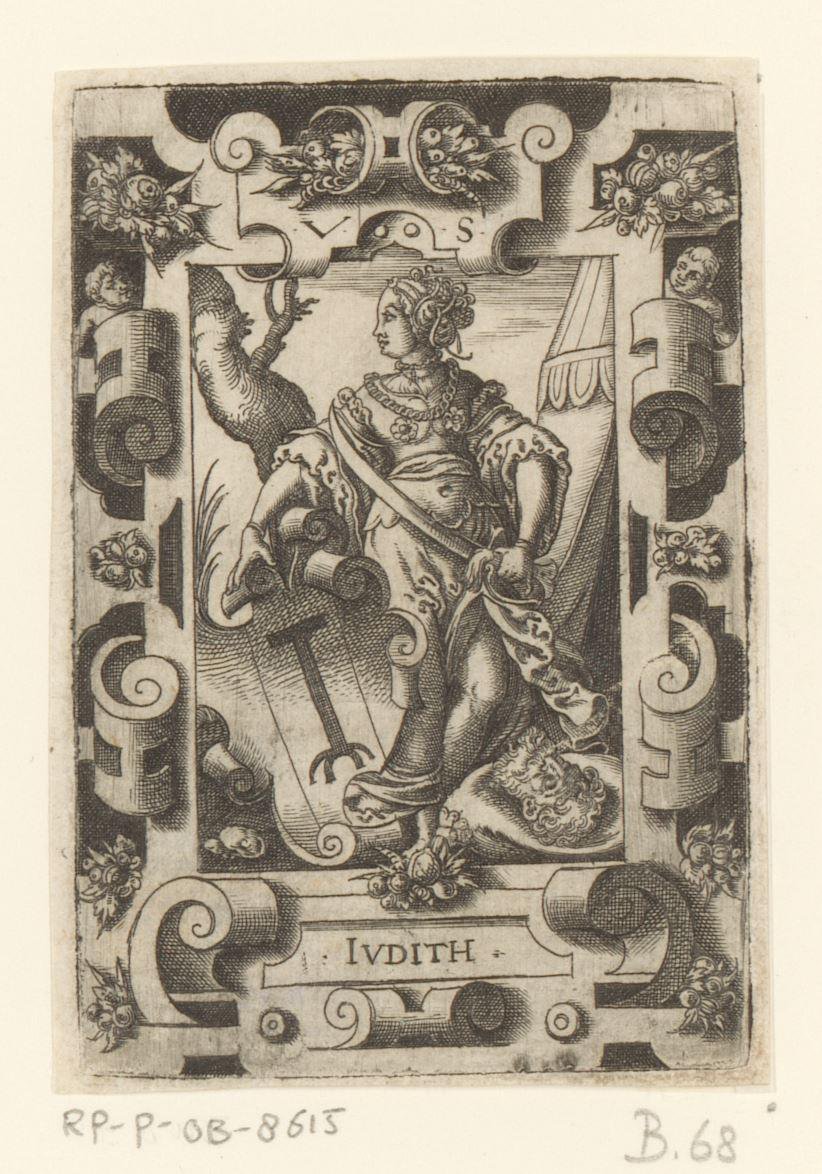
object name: print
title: Judit met wapenschild in rolwerk omlijsting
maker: virgilius solis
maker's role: draughtsman, print maker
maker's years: 1514-1562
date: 1524-1562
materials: paper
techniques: engraving, etching, intaglio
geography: nuremberg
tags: judith (one of the nine worthiest women)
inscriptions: collector's mark: Lugt 2228, number: ‘64’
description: Deze prent maakt deel uit van een serie bestaande uit negen prenten van de vrouwelijke Negen Besten in rolwerk omlijstingen.